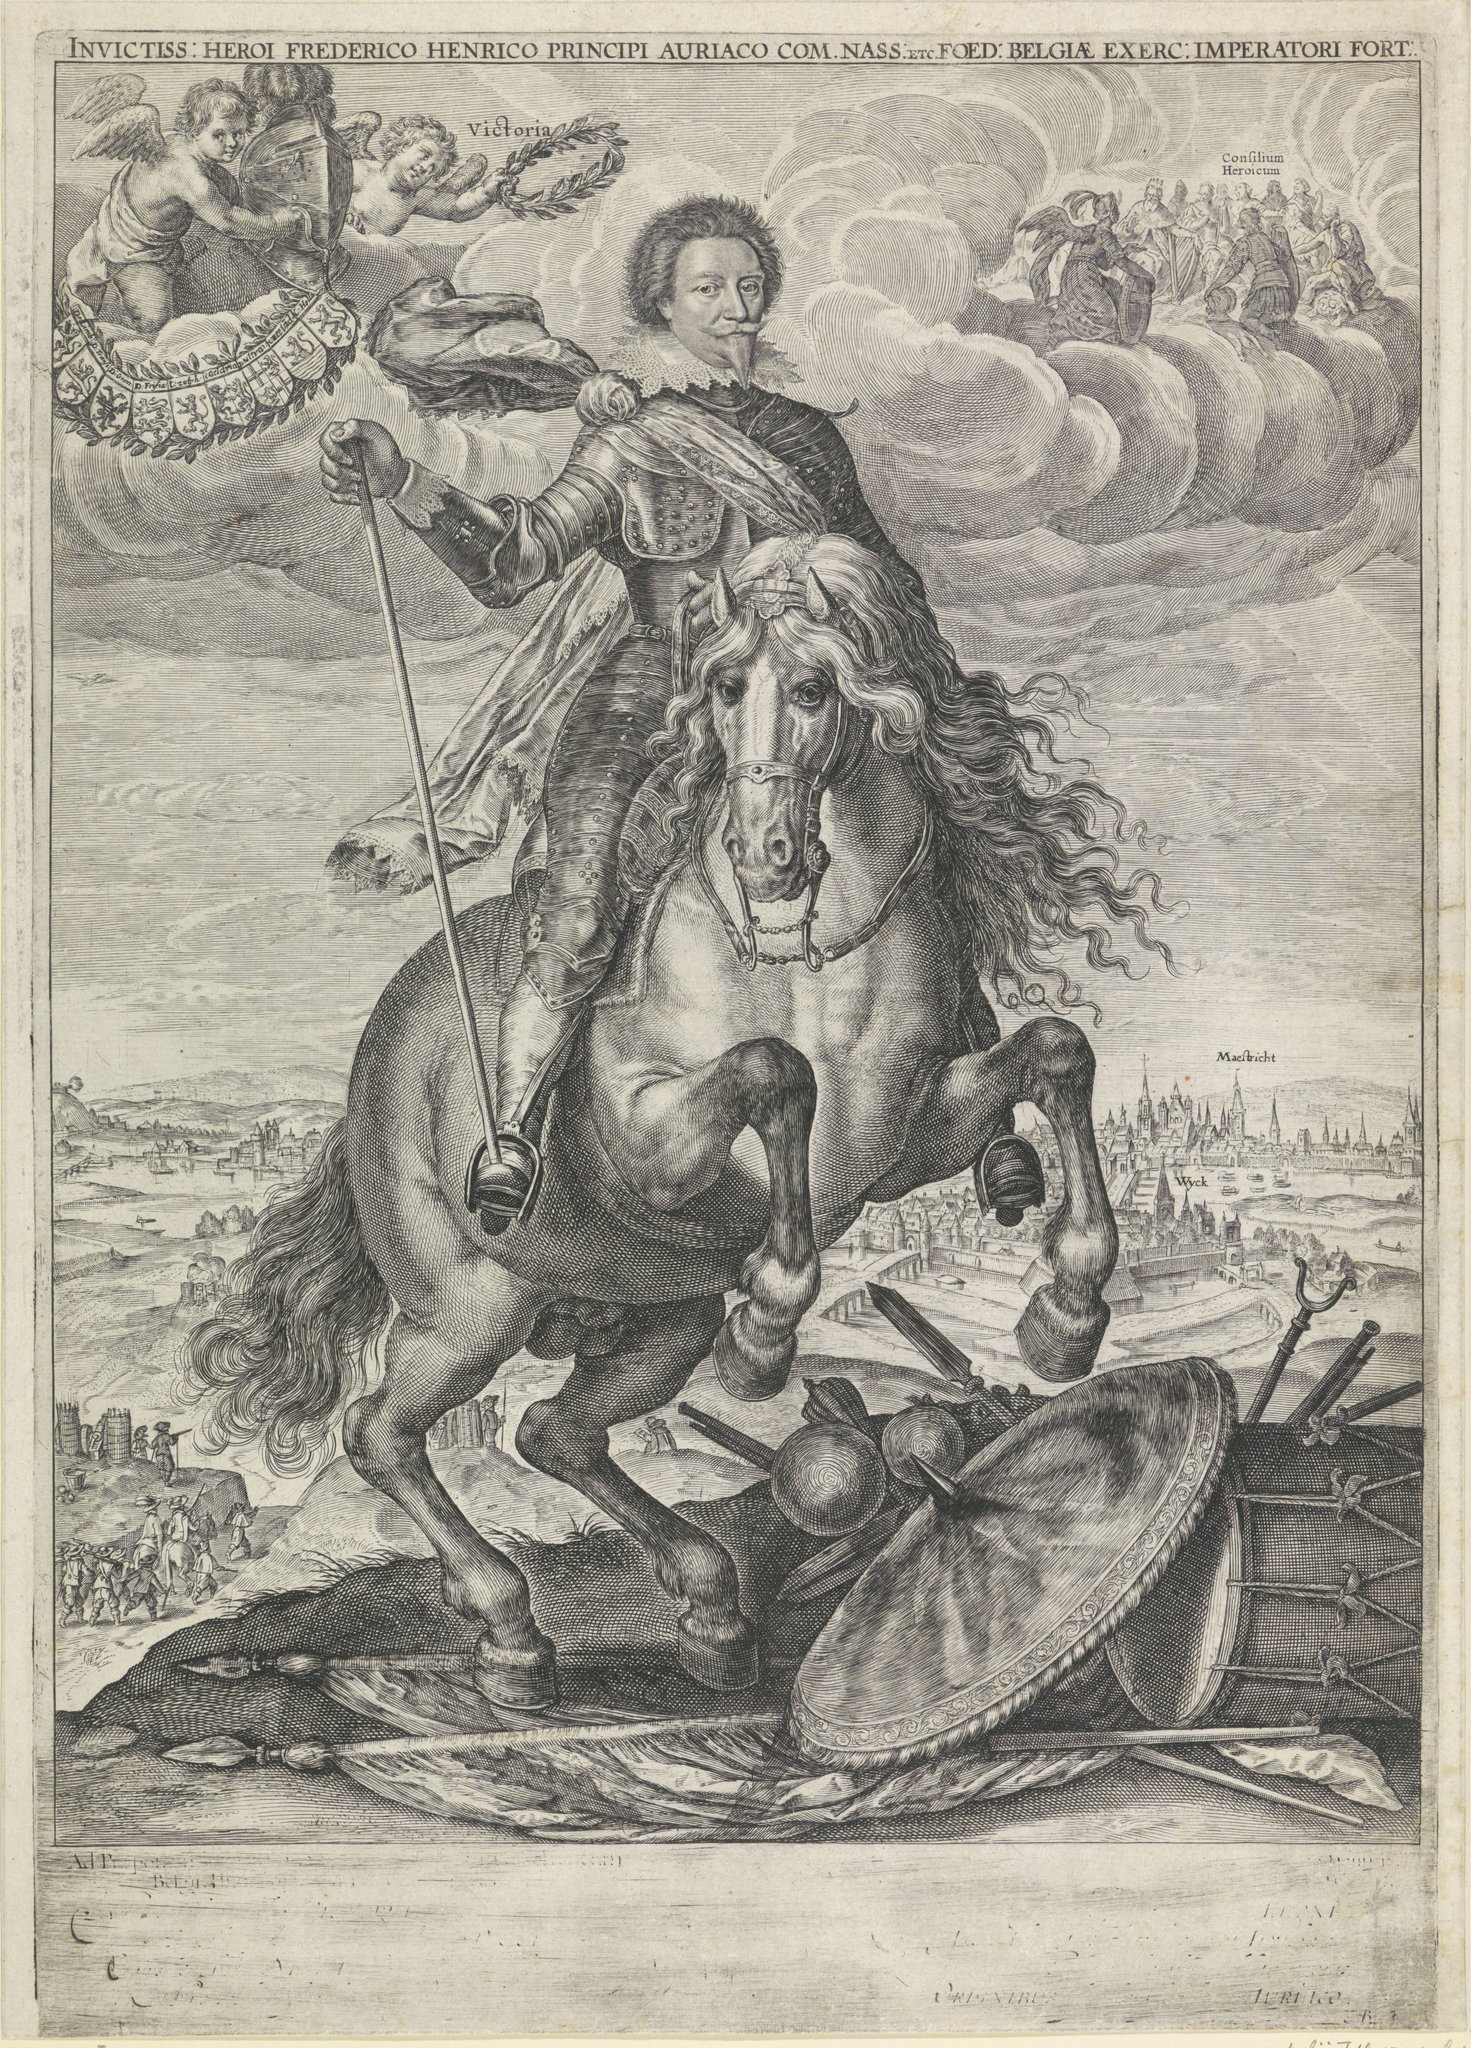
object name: print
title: Ruiterportret van Frederik Hendrik, prins van Oranje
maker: crispijn van de passe (i)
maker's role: draughtsman, print maker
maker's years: 1564-1637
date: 1632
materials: paper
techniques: engraving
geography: utrecht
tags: the hague, frederick henry (prince of orange)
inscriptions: collector's mark: Lugt 963, collector's mark: Lugt 2228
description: Ruiterportret van Frederik Hendrik na de verovering van Maastricht, augustus 1632. De stadhouder op een steigerend paard, voor de voeten wapentuig. In de lucht links twee putti met helm, krans met provinciewapens en lauwerkrans. Rechts het heldenberaad. Op de achtergrond de stad Maastricht. In de marge zijn nog sporen van de weggepolijste inscriptie.